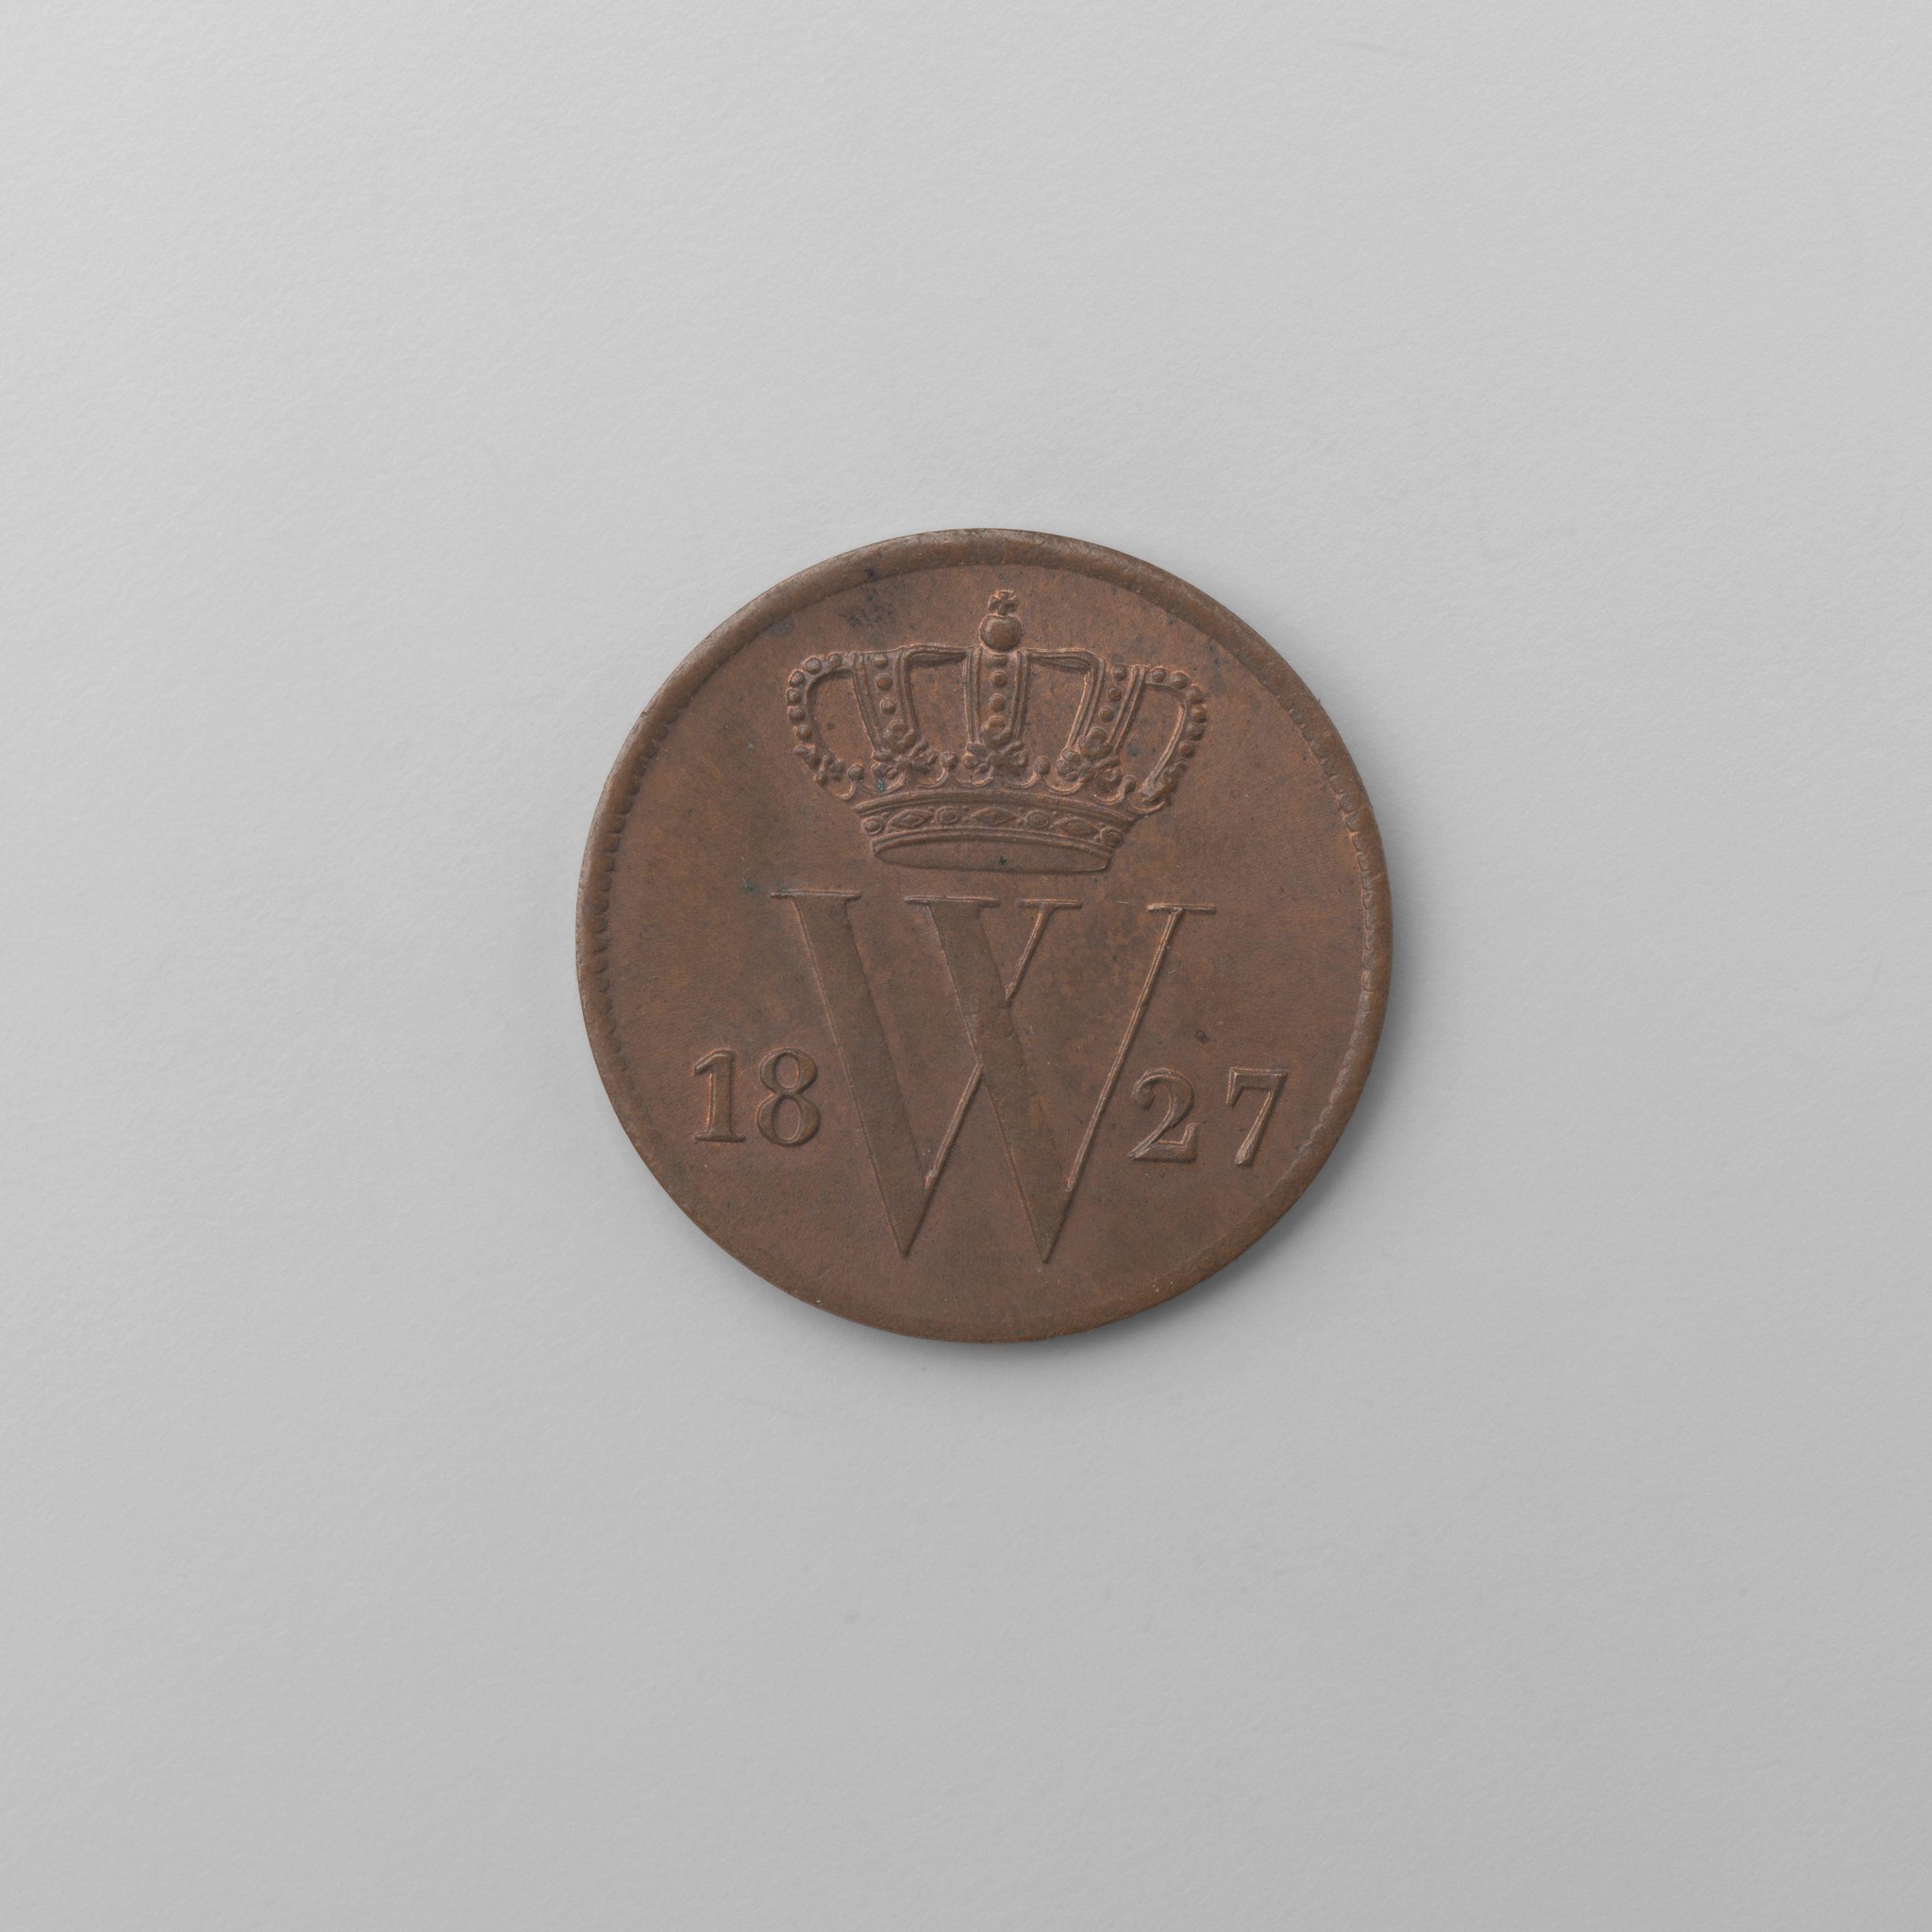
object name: coin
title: Nederlandse cent, 1827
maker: william i of the netherlands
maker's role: koning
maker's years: 1772-1843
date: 1827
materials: copper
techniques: striking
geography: utrecht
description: Koperen munt. Voorzijde: tussen jaartal gekroonde rechte letter W. Keerzijde: tussen waarde-aanduiding 1 C. gekroond rijkswapenschild. Gladde rand.